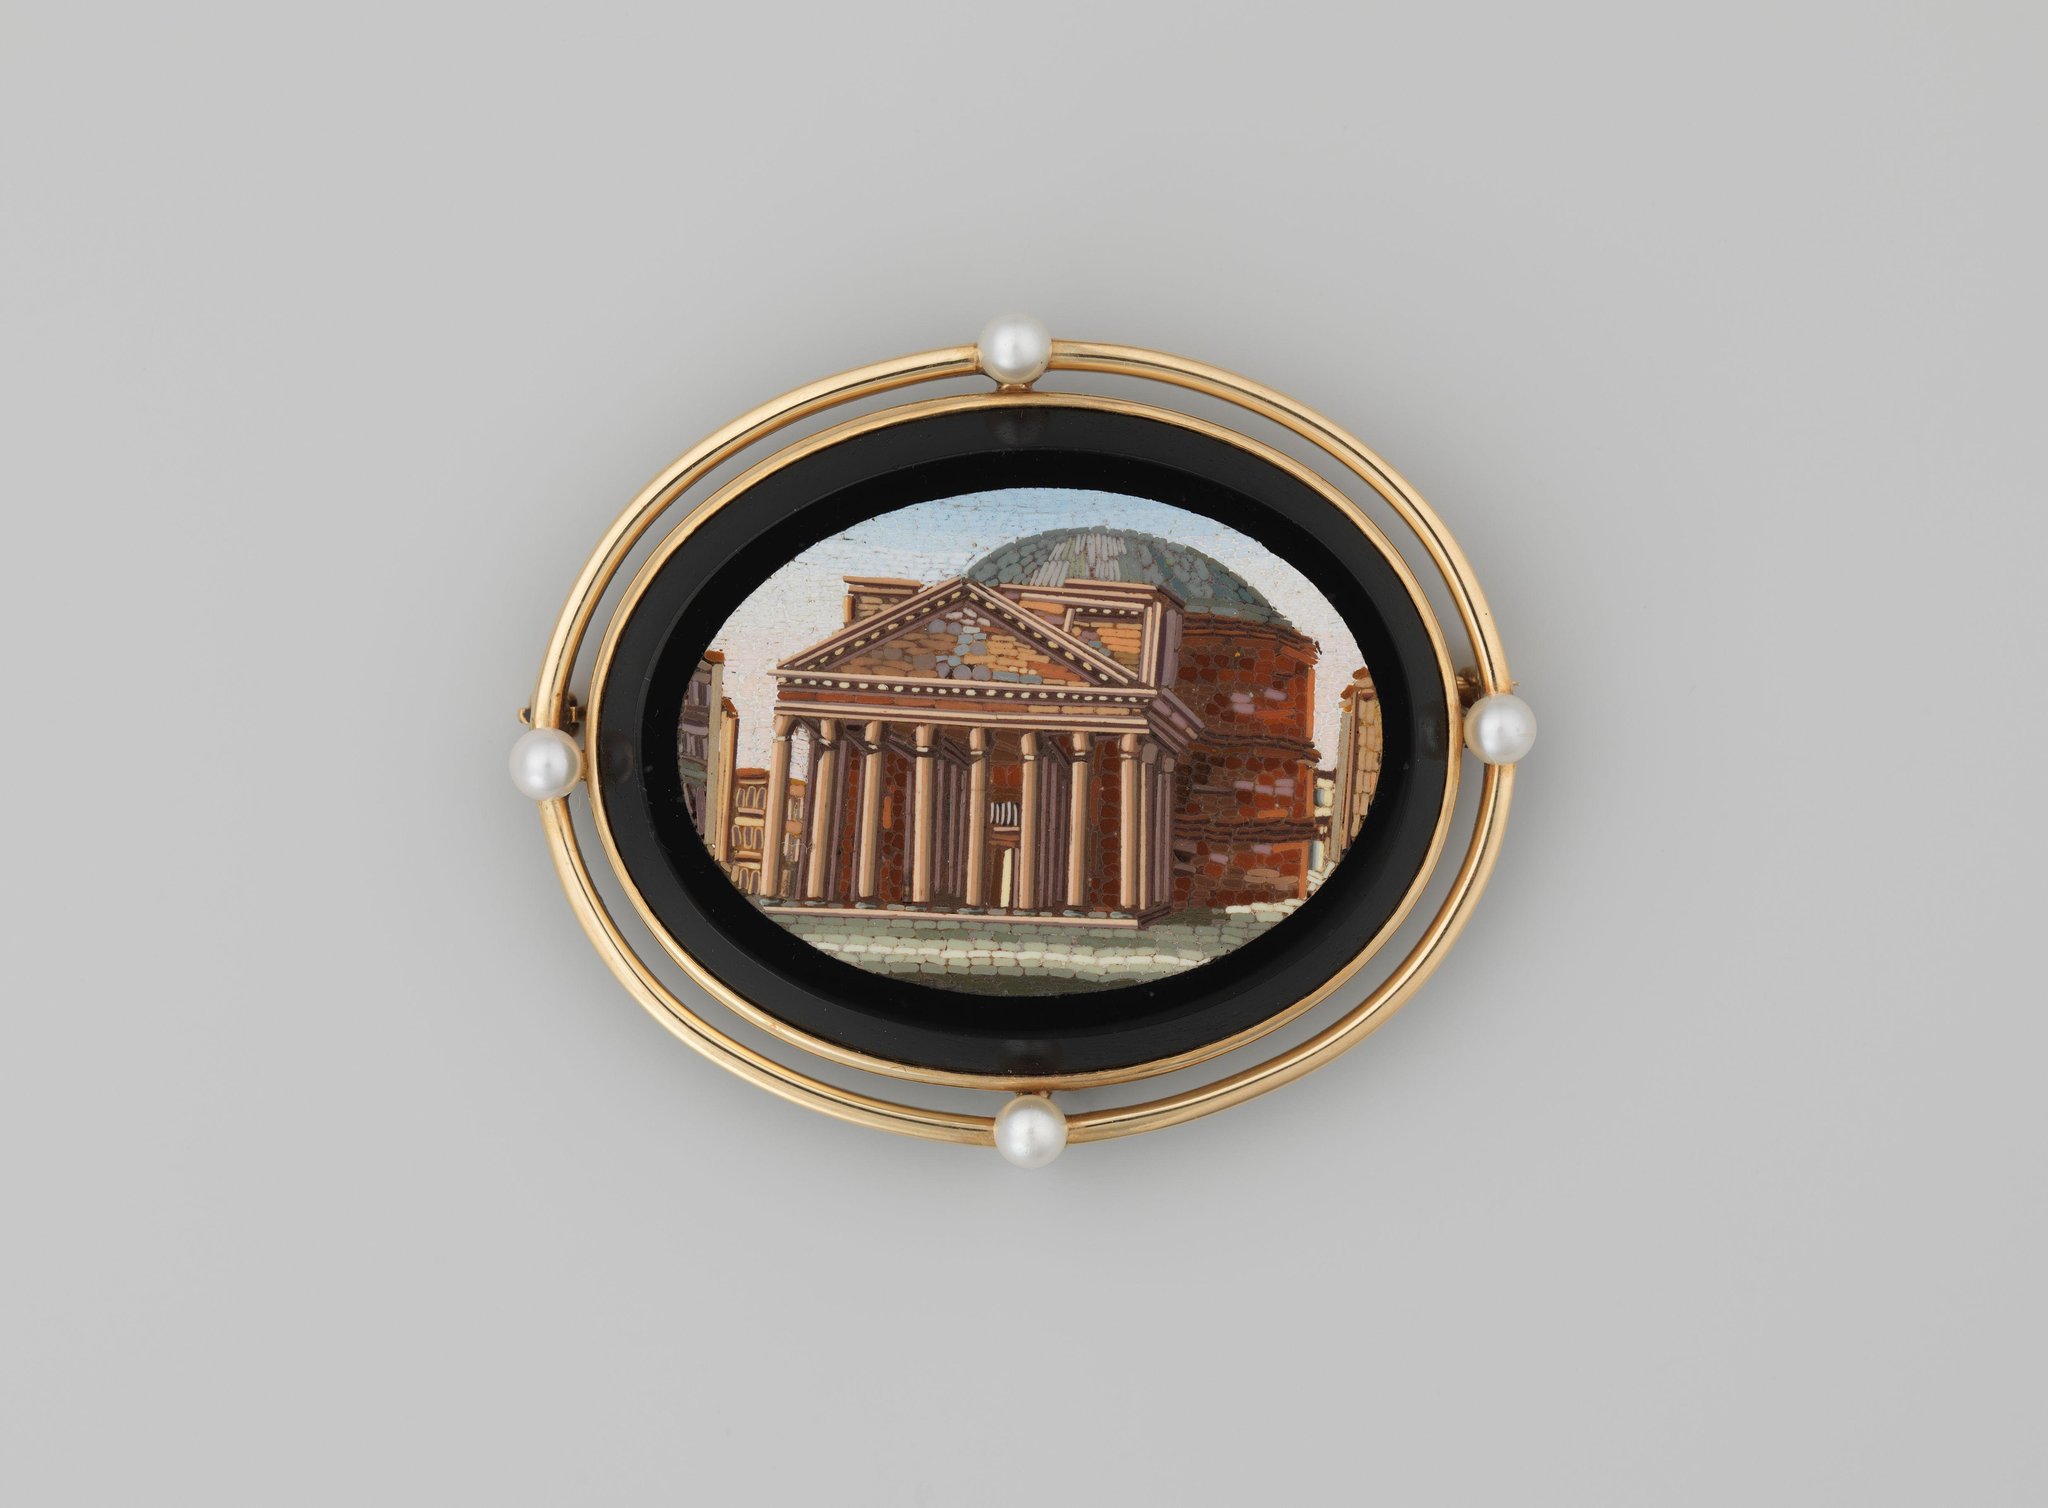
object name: brooch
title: Broche van goud en glas met Pantheon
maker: Anonymous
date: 1880-1900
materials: glass, gold, onyx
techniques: mosaic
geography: rome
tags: pantheon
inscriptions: alloy mark: ‘585’, : ‘14K’, : ‘585 in blaadje’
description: Broche van onyx ingelegd met micromozaïek van glas gevat in dubbele rand van goud, met voorsteling van het Pantheon. Op de kwartieren gezet met gecultiveerde parels. De brochering is een haakoog met een sureté.